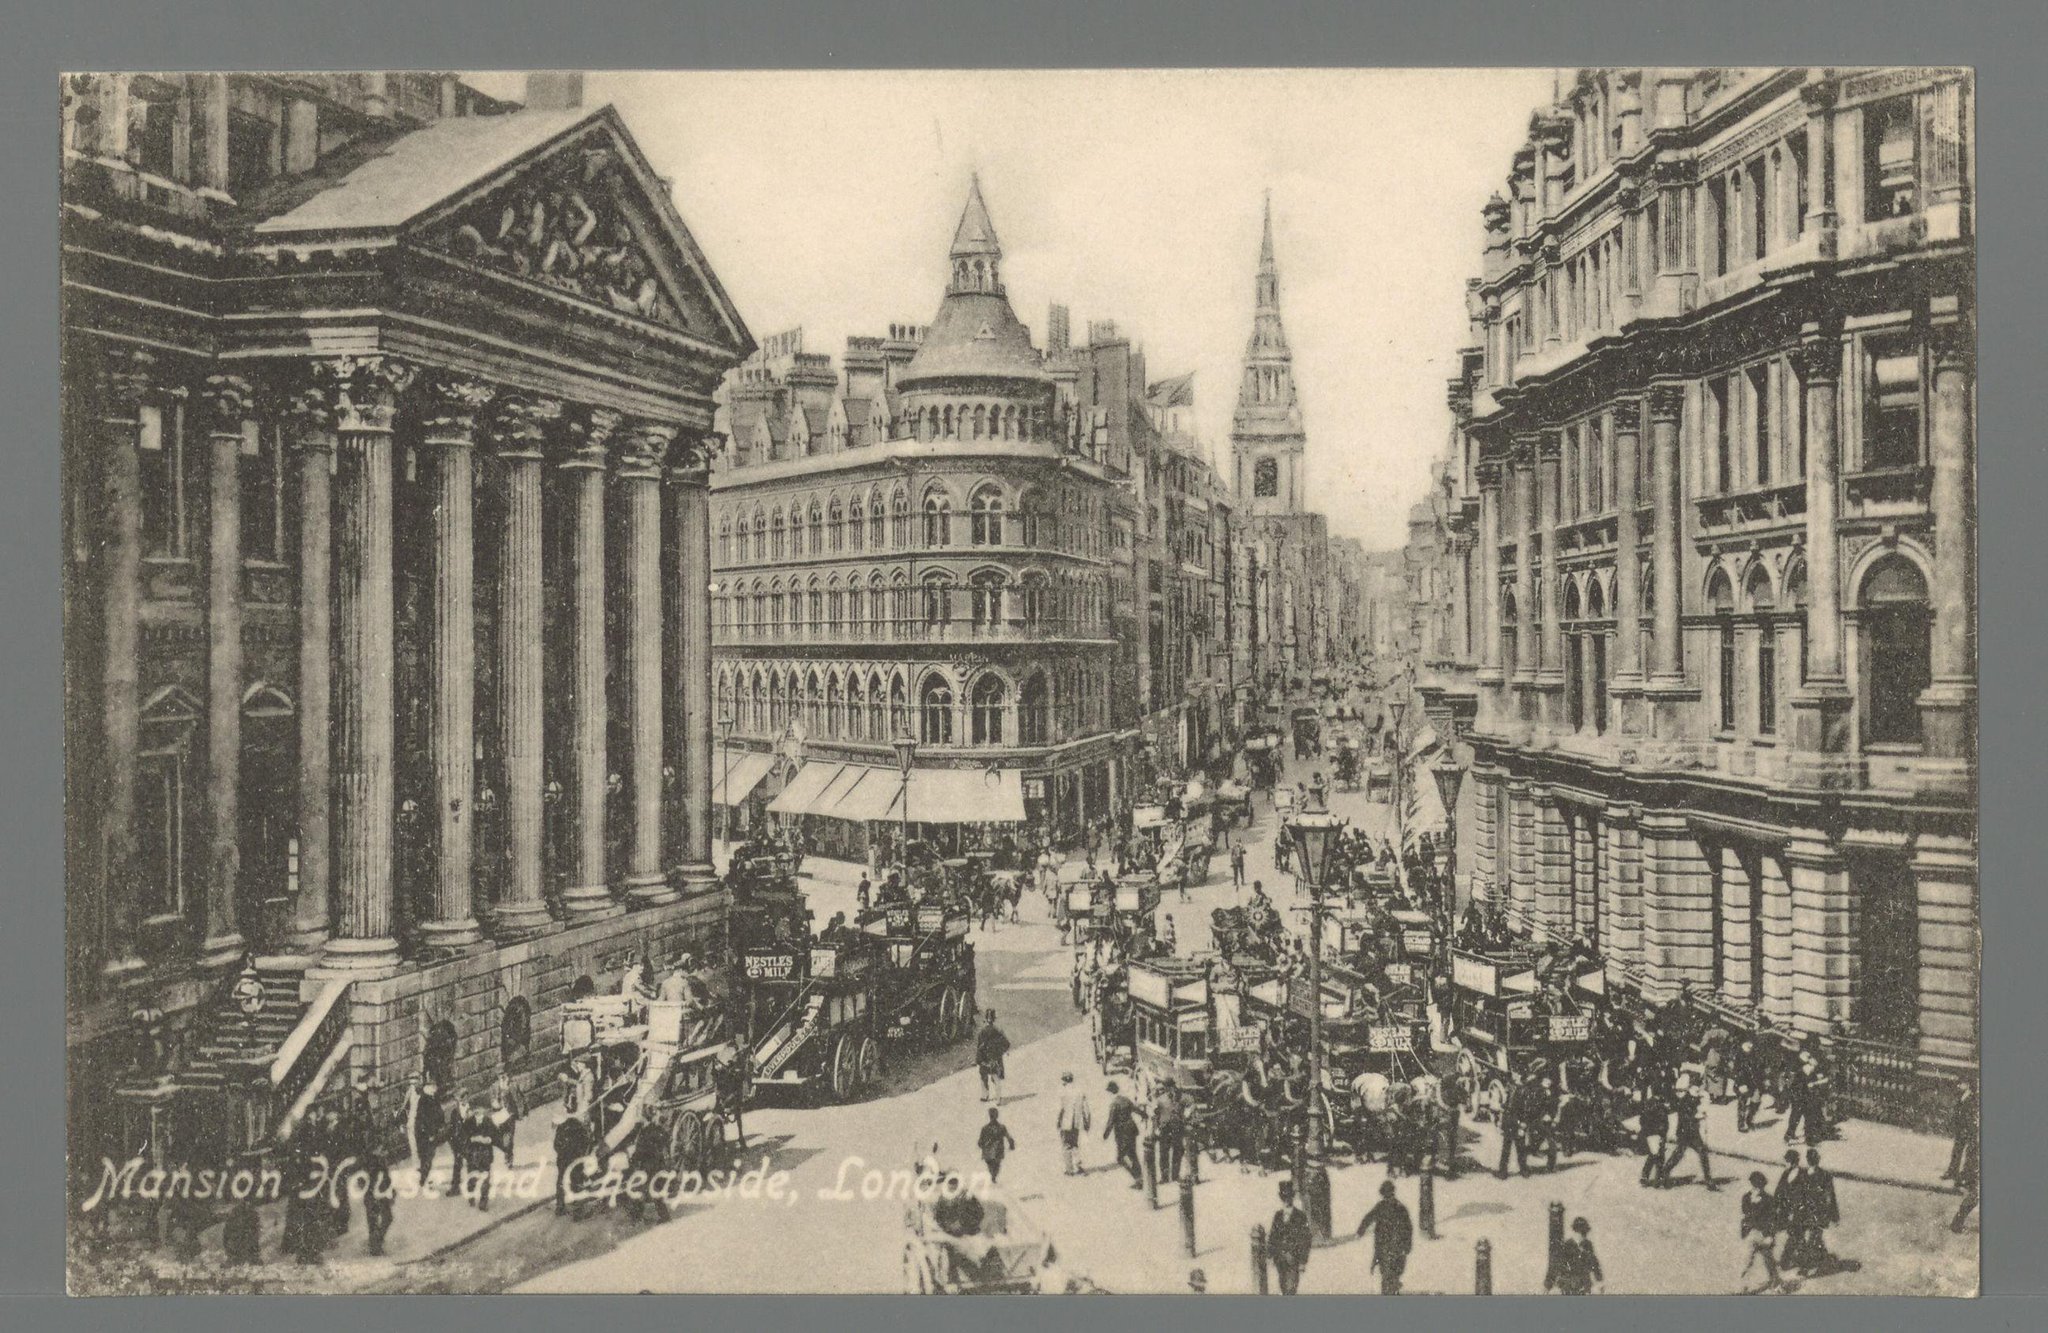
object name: photomechanical print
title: Valentine's Series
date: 1902-1930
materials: cardboard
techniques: photograph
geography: london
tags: street